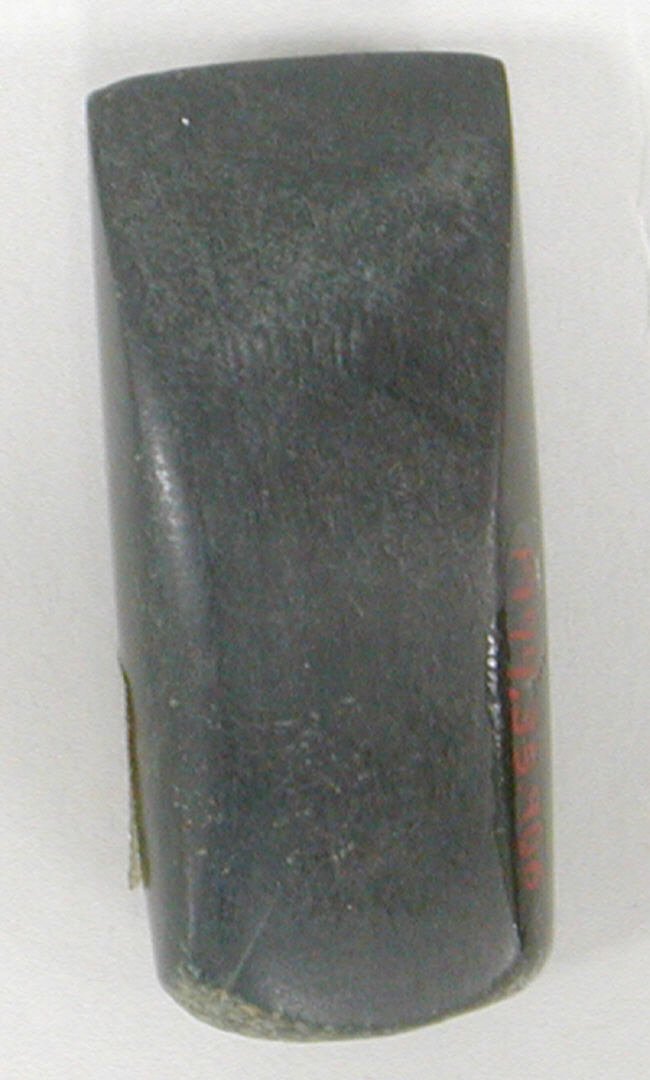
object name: chisel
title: Stone Chisel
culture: mexican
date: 1501-1600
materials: stone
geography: mexico